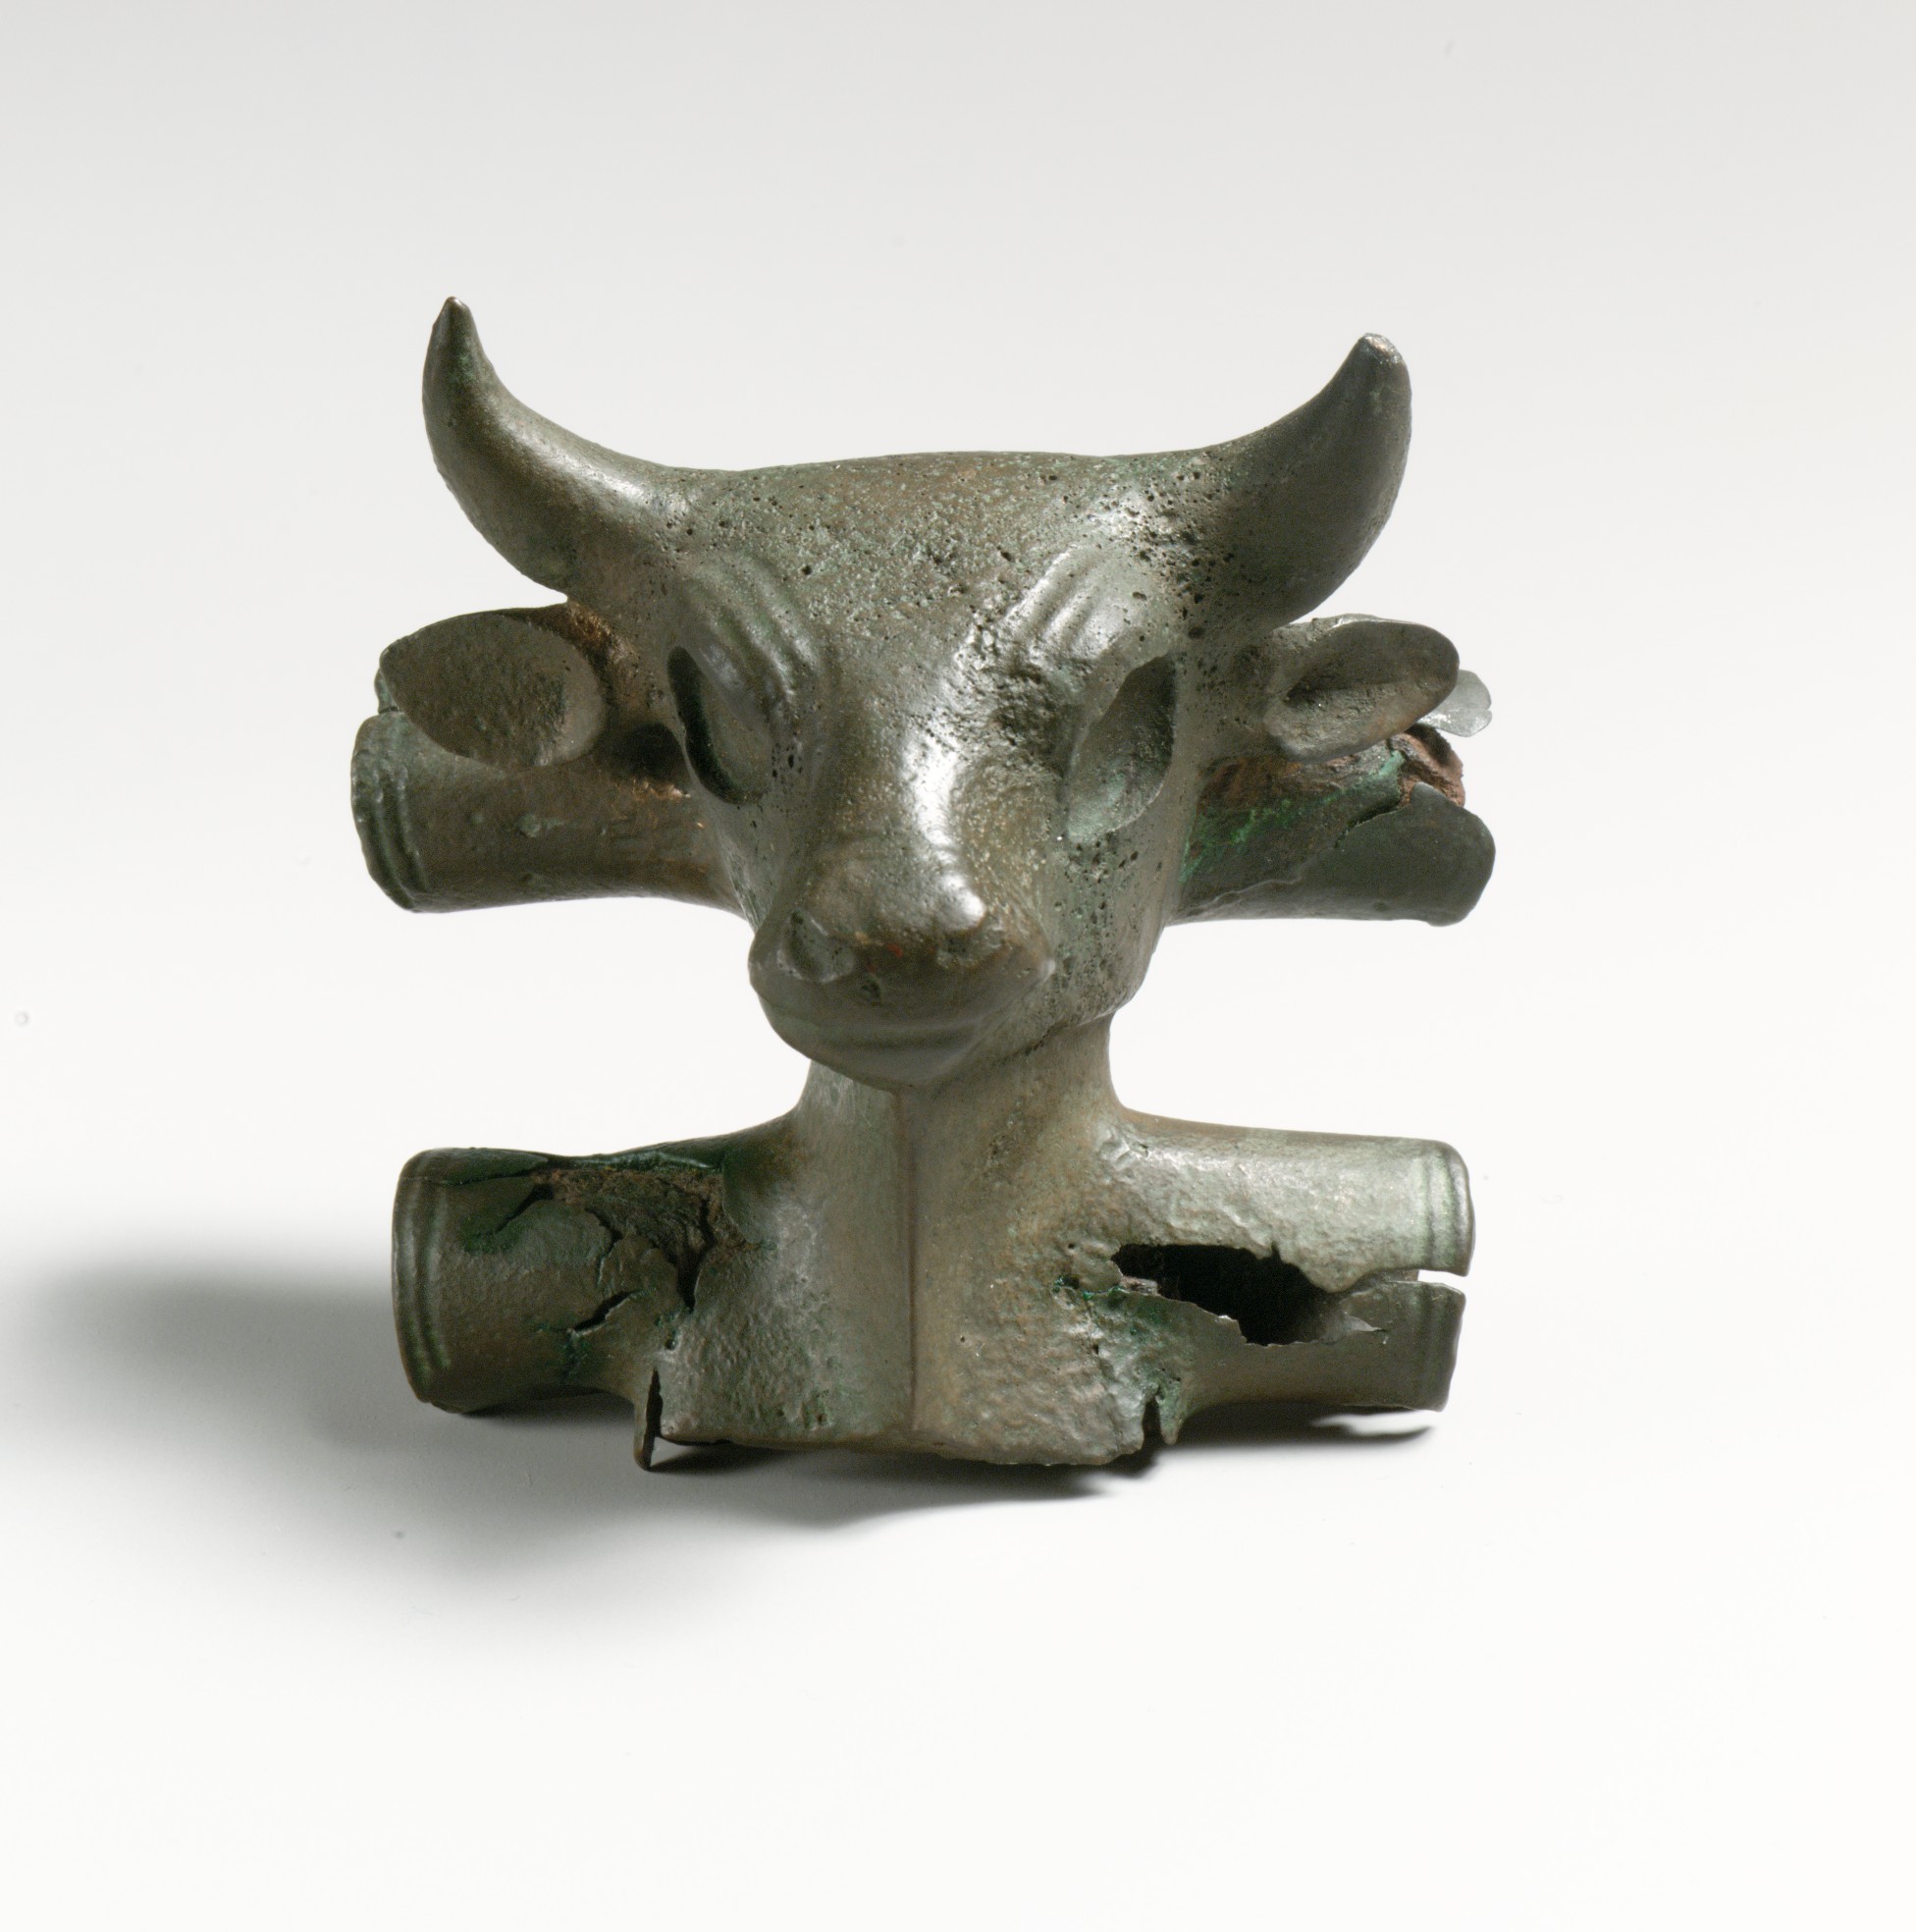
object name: attachment in the form of a bull's head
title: Bronze bull's head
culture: cypriot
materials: bronze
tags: bulls